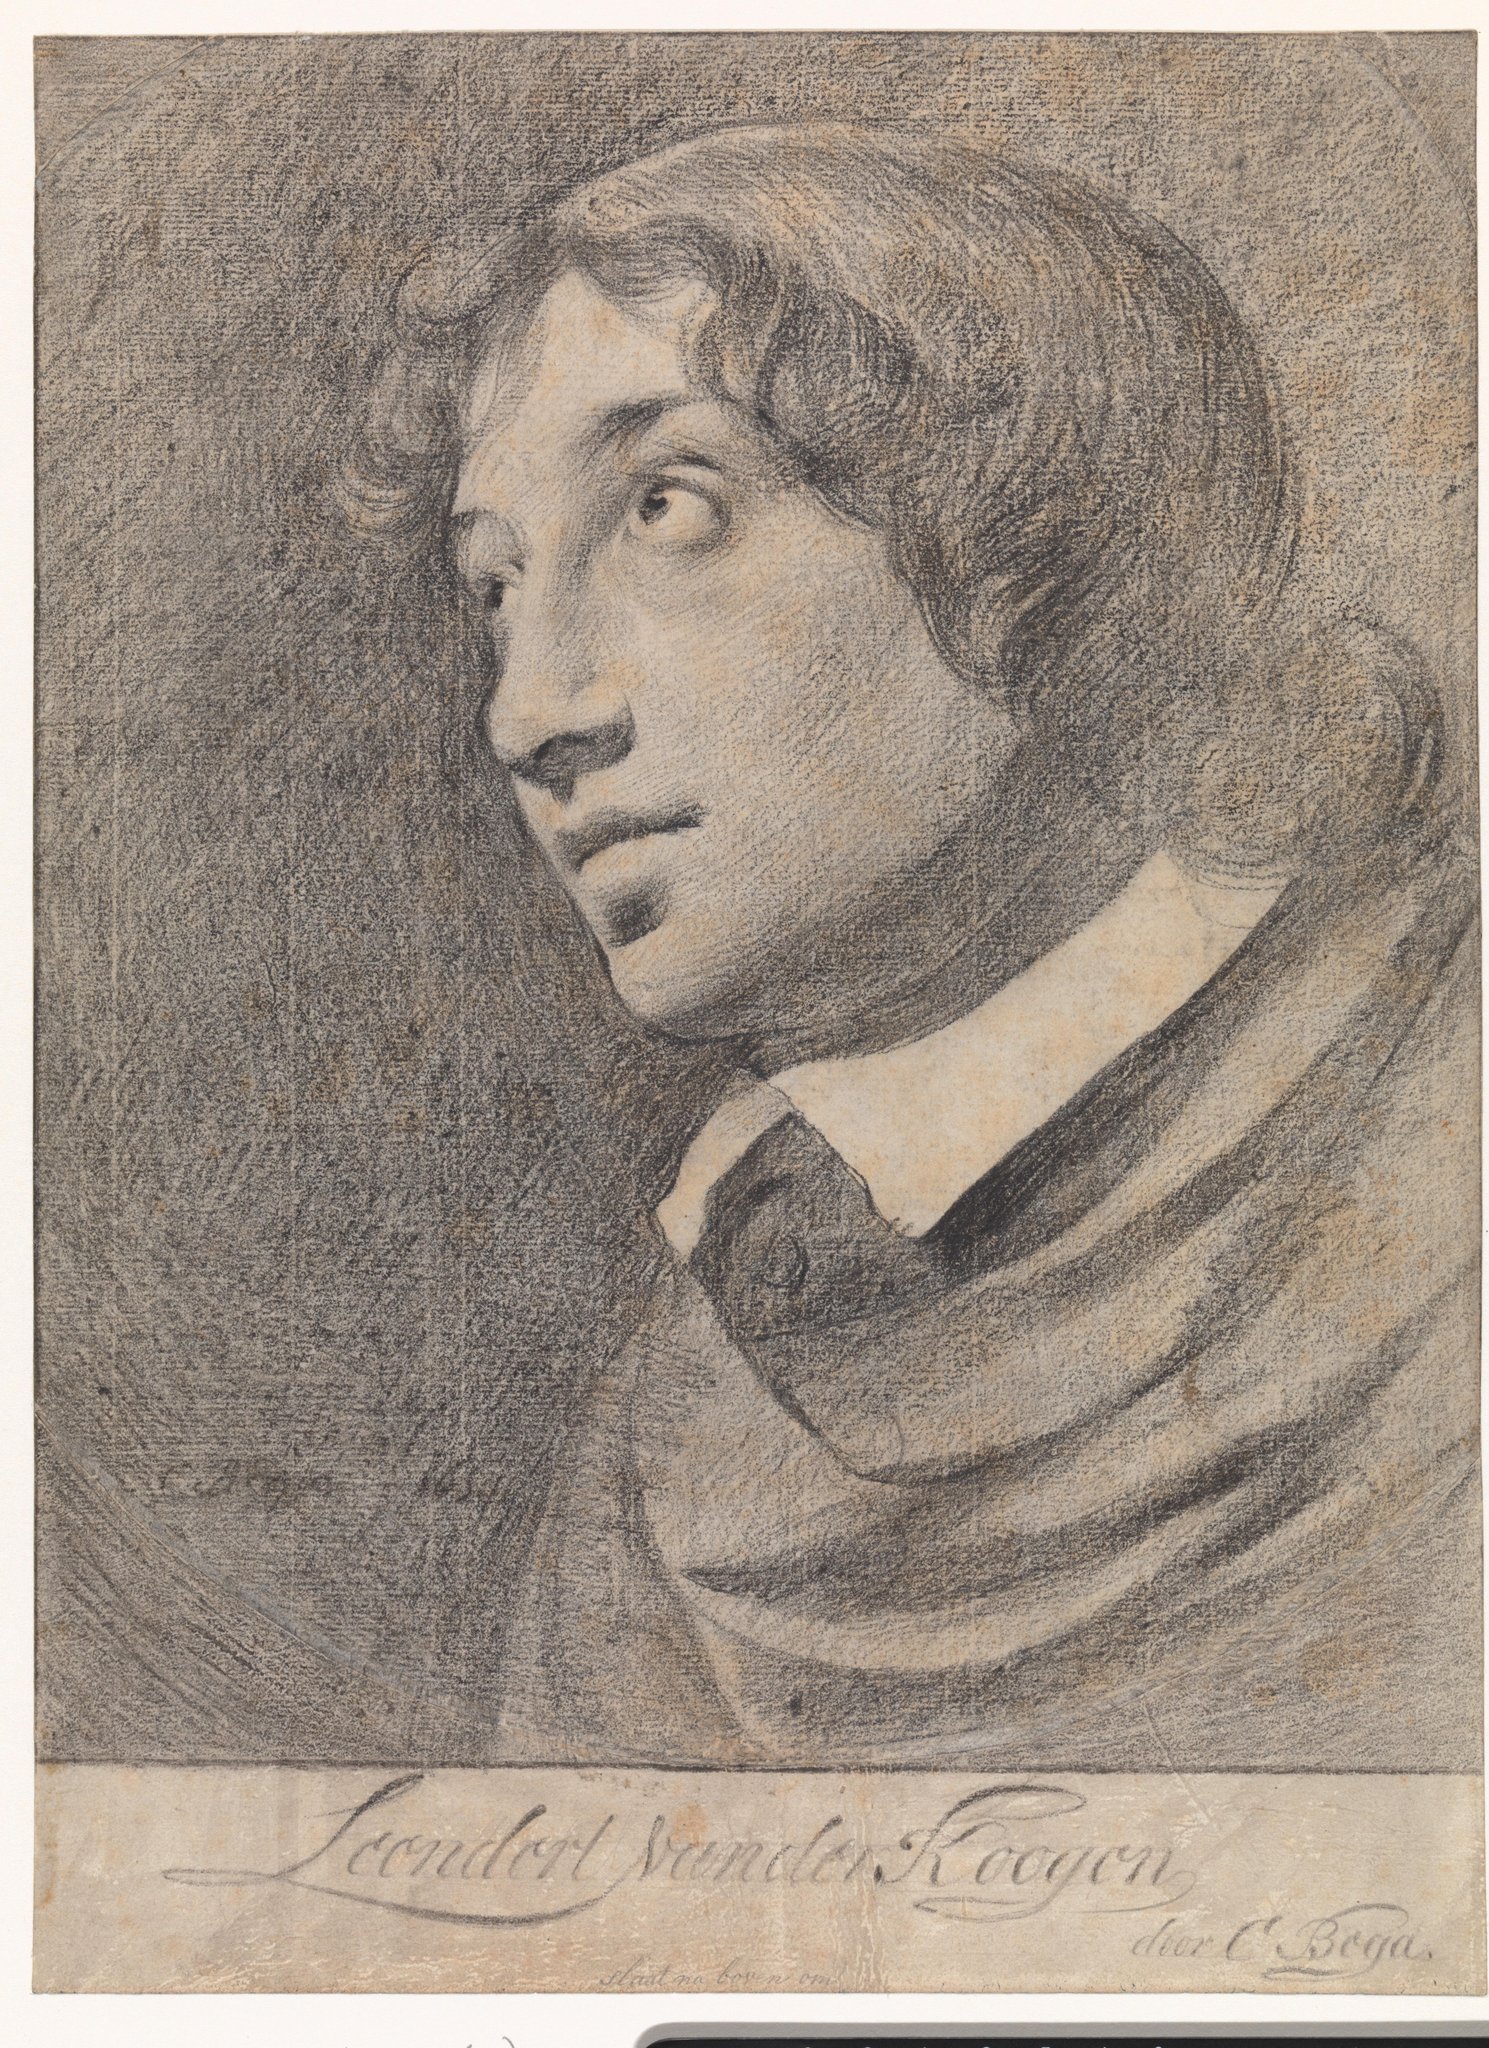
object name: drawing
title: Portrait of Leendert van der Cooghen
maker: cornelis pietersz. bega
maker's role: draughtsman, painter, print maker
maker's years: 1631-1664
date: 1654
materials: chalk, paper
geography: haarlem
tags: leendert van der cooghen, historical persons, portrait, self-portrait of painter, portrait, self-portrait of artist, portrait, self-portrait of draughtsman